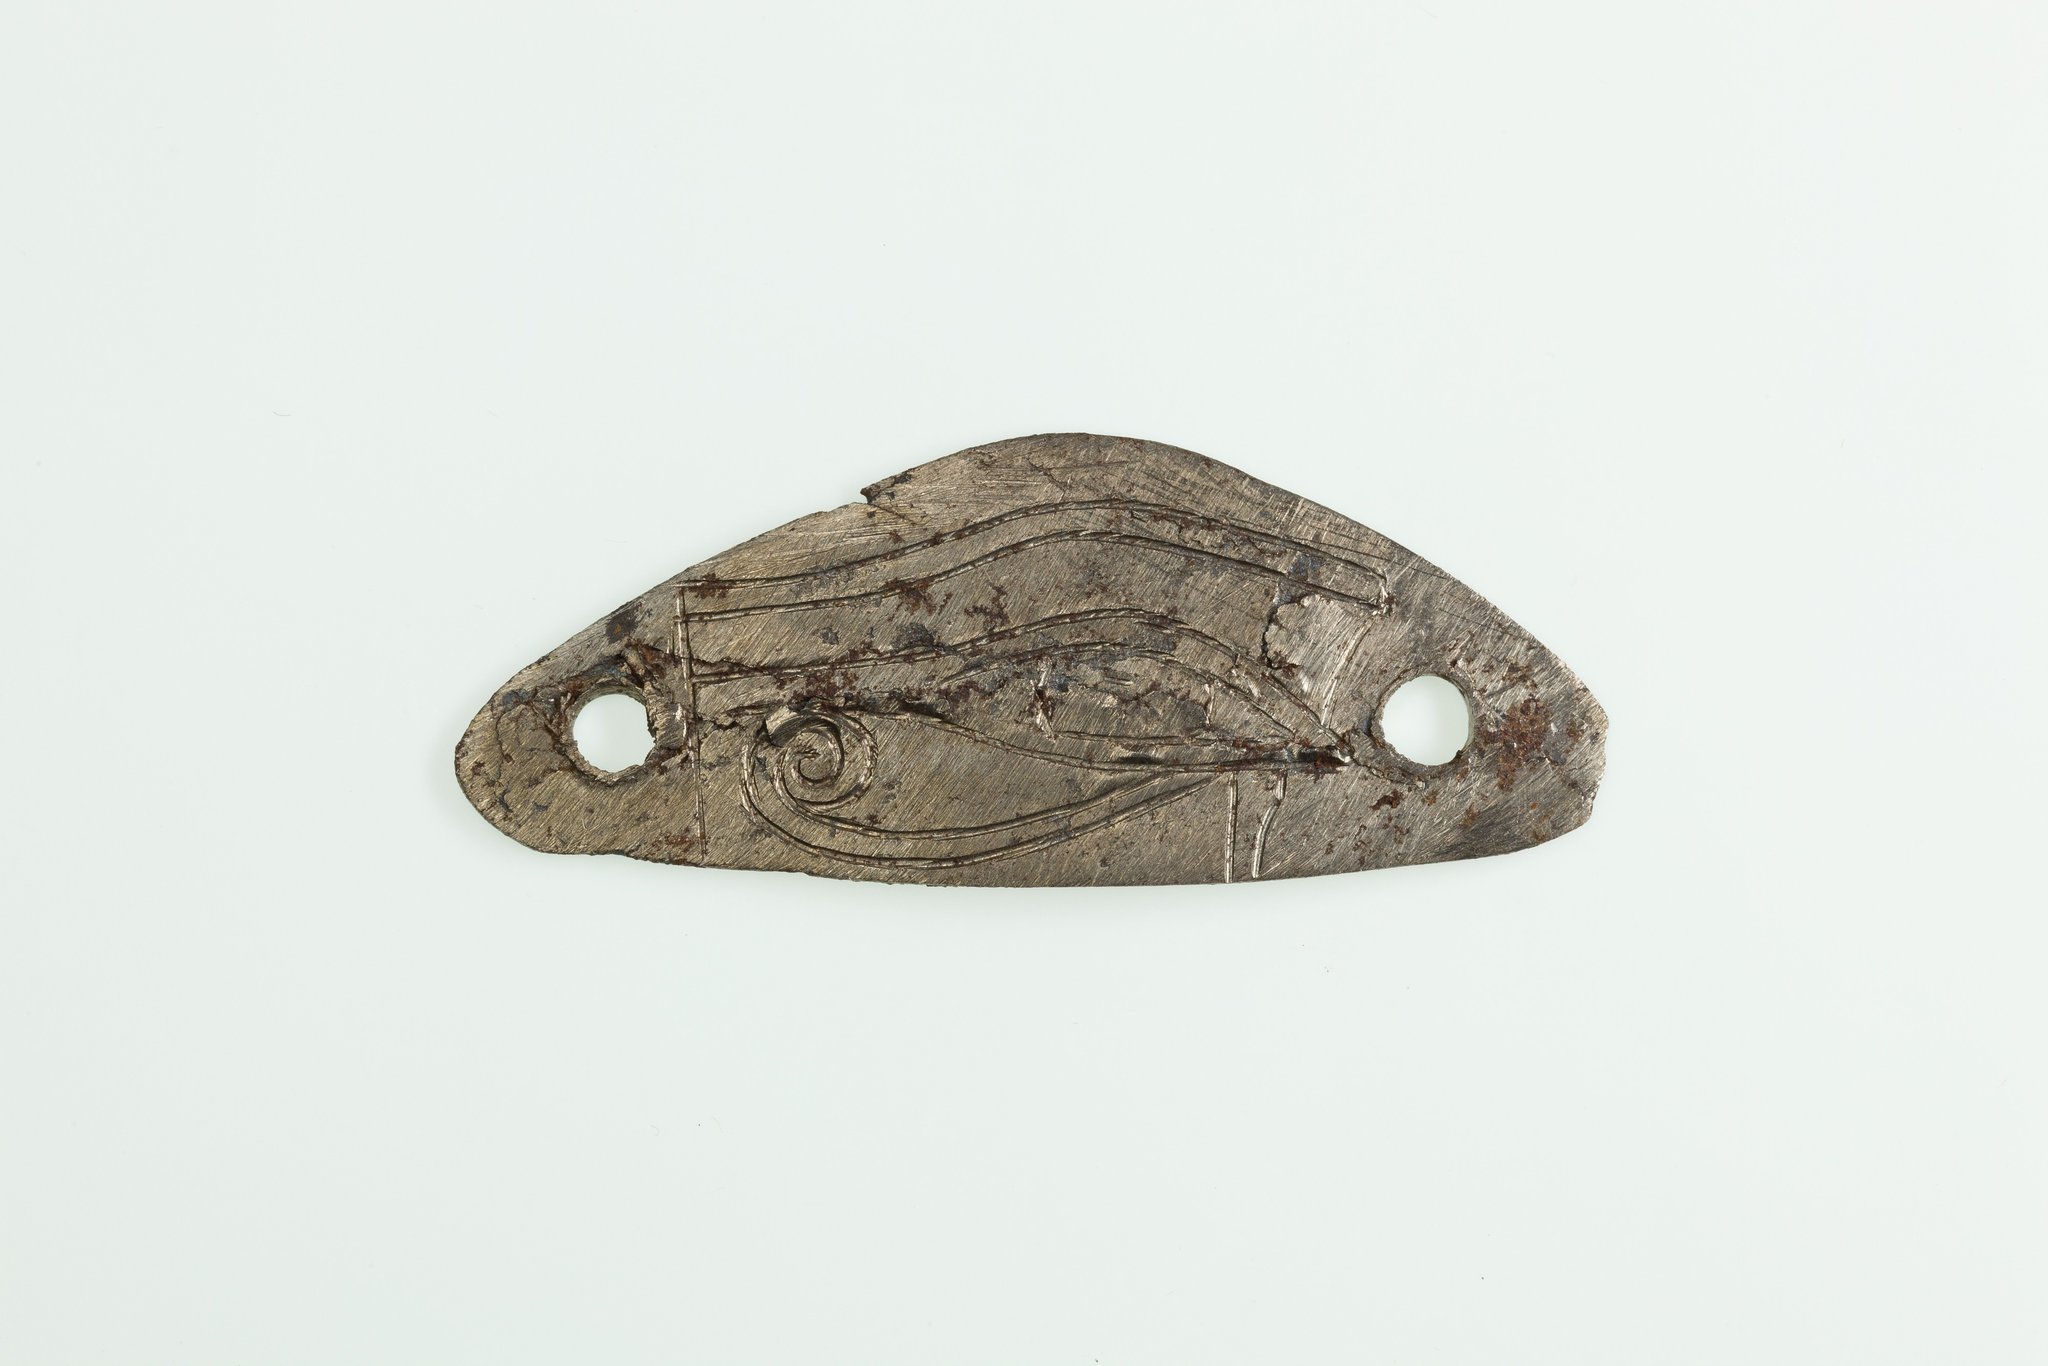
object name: amulet, plaque with wadjet eye, nesenaset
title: Wedjat eye plaque of Nesenaset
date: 1070-945 BCE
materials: iron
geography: egypt